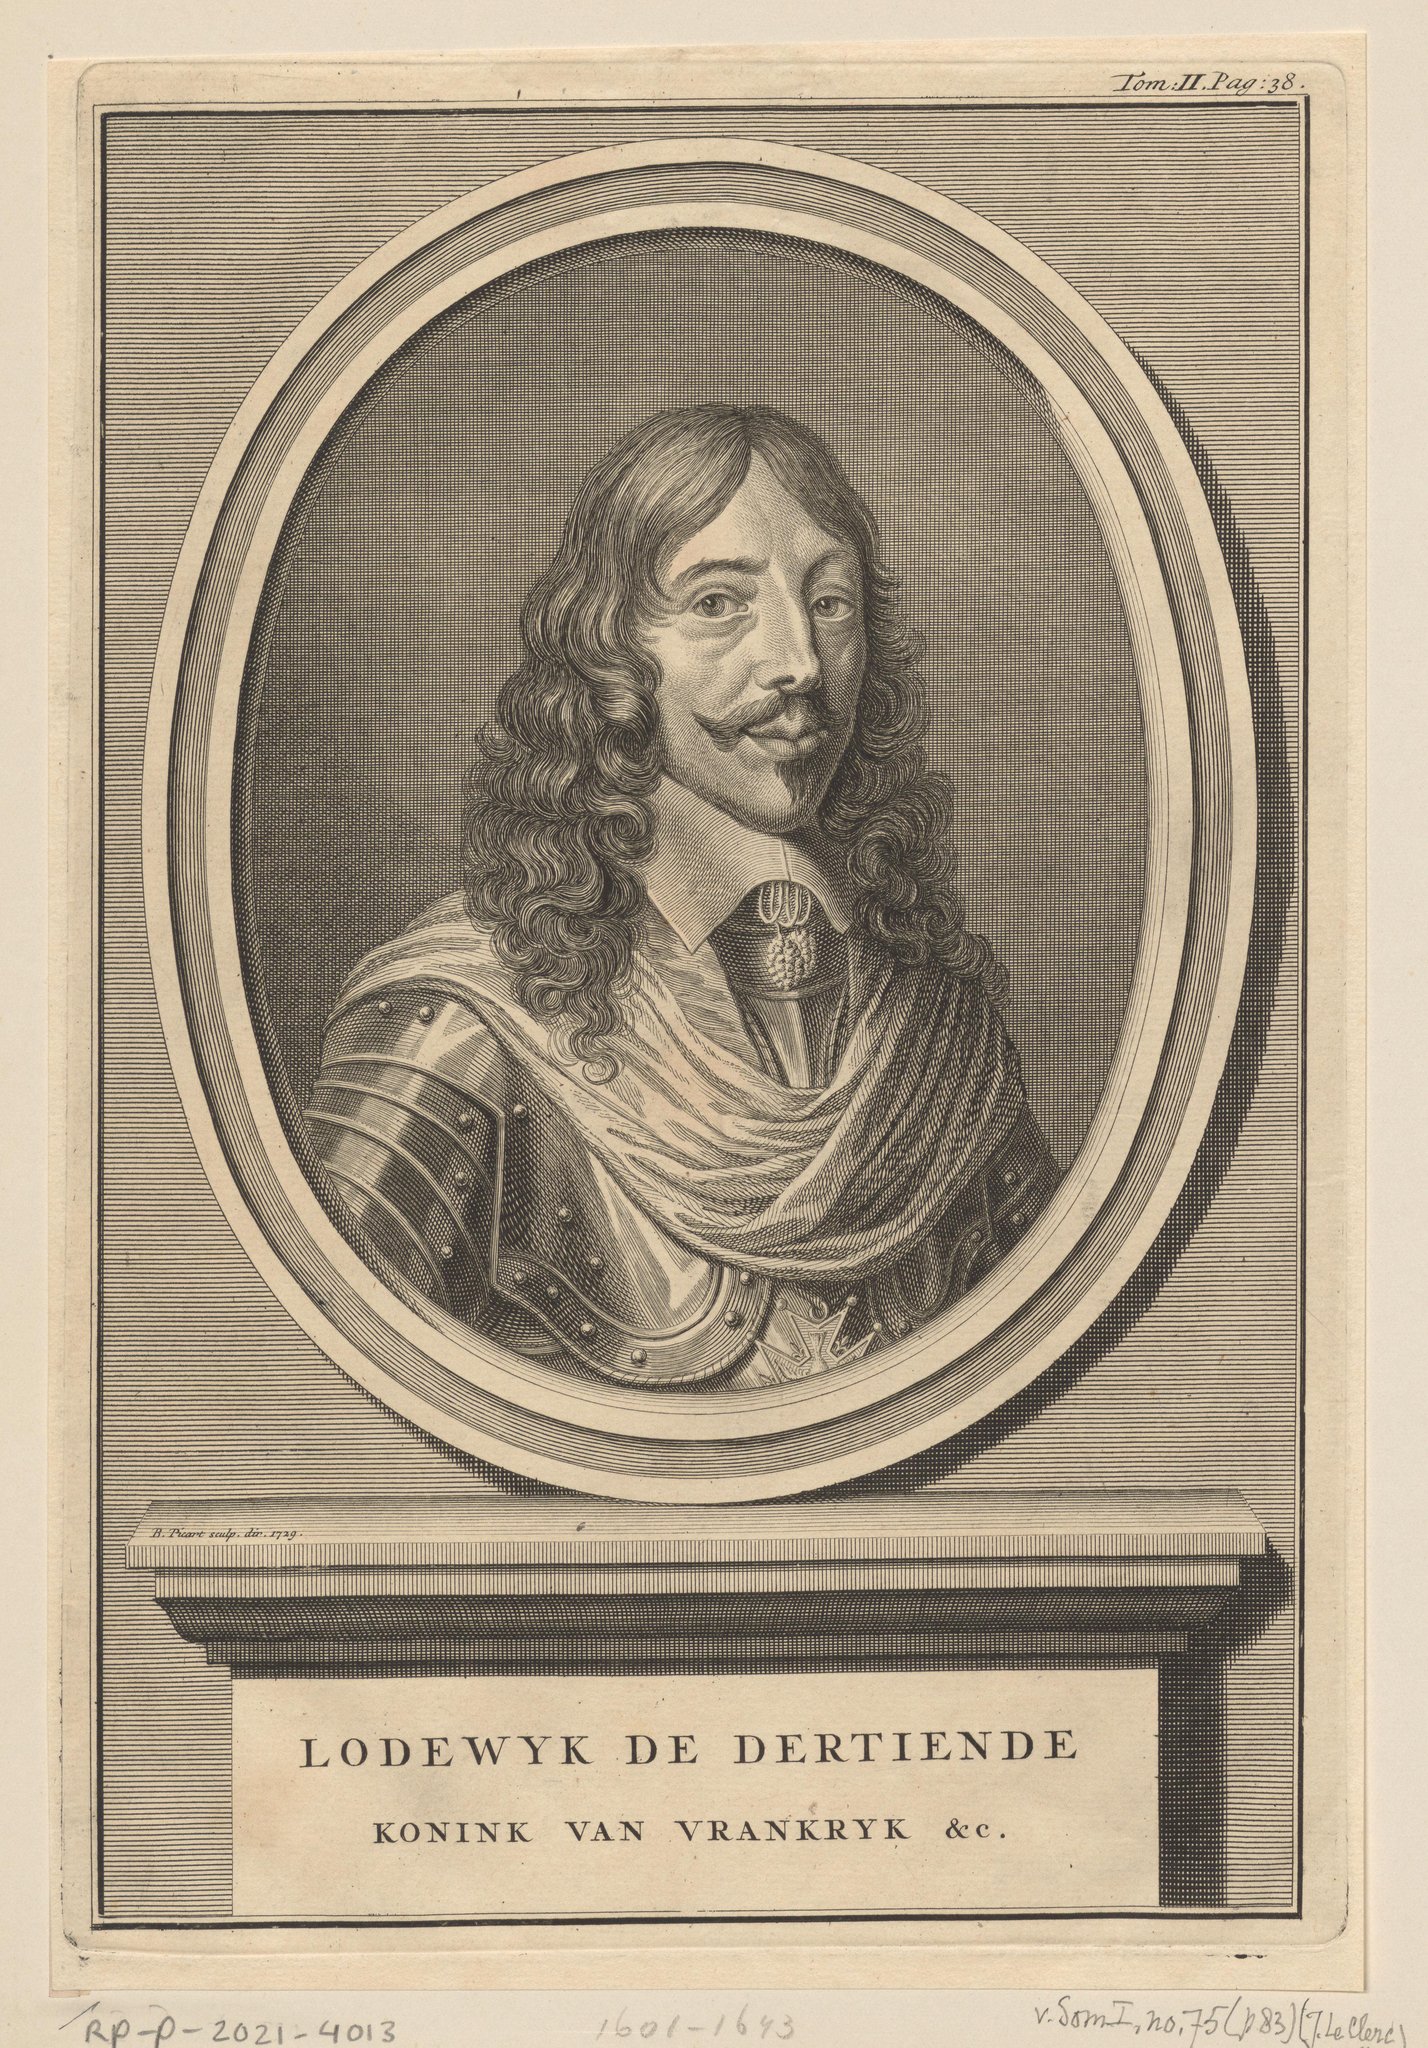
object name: book illustration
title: Portret van Lodewijk XIII van Frankrijk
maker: bernard picart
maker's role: draughtsman, print maker, publisher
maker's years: 1673-1733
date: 1729-1738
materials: paper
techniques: engraving, etching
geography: northern netherlands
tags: lodewijk xiii (koning van frankrijk), ornament ~ medallion, armour, historical persons, king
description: Prent waarschijnlijk uit: Le Clerc, Jean. Geschiedenissen der Vereenigde Nederlanden. Amsterdam: Zacharias Chatelain, 1730, dl. 2. Of uit de tweede druk uit 1738.